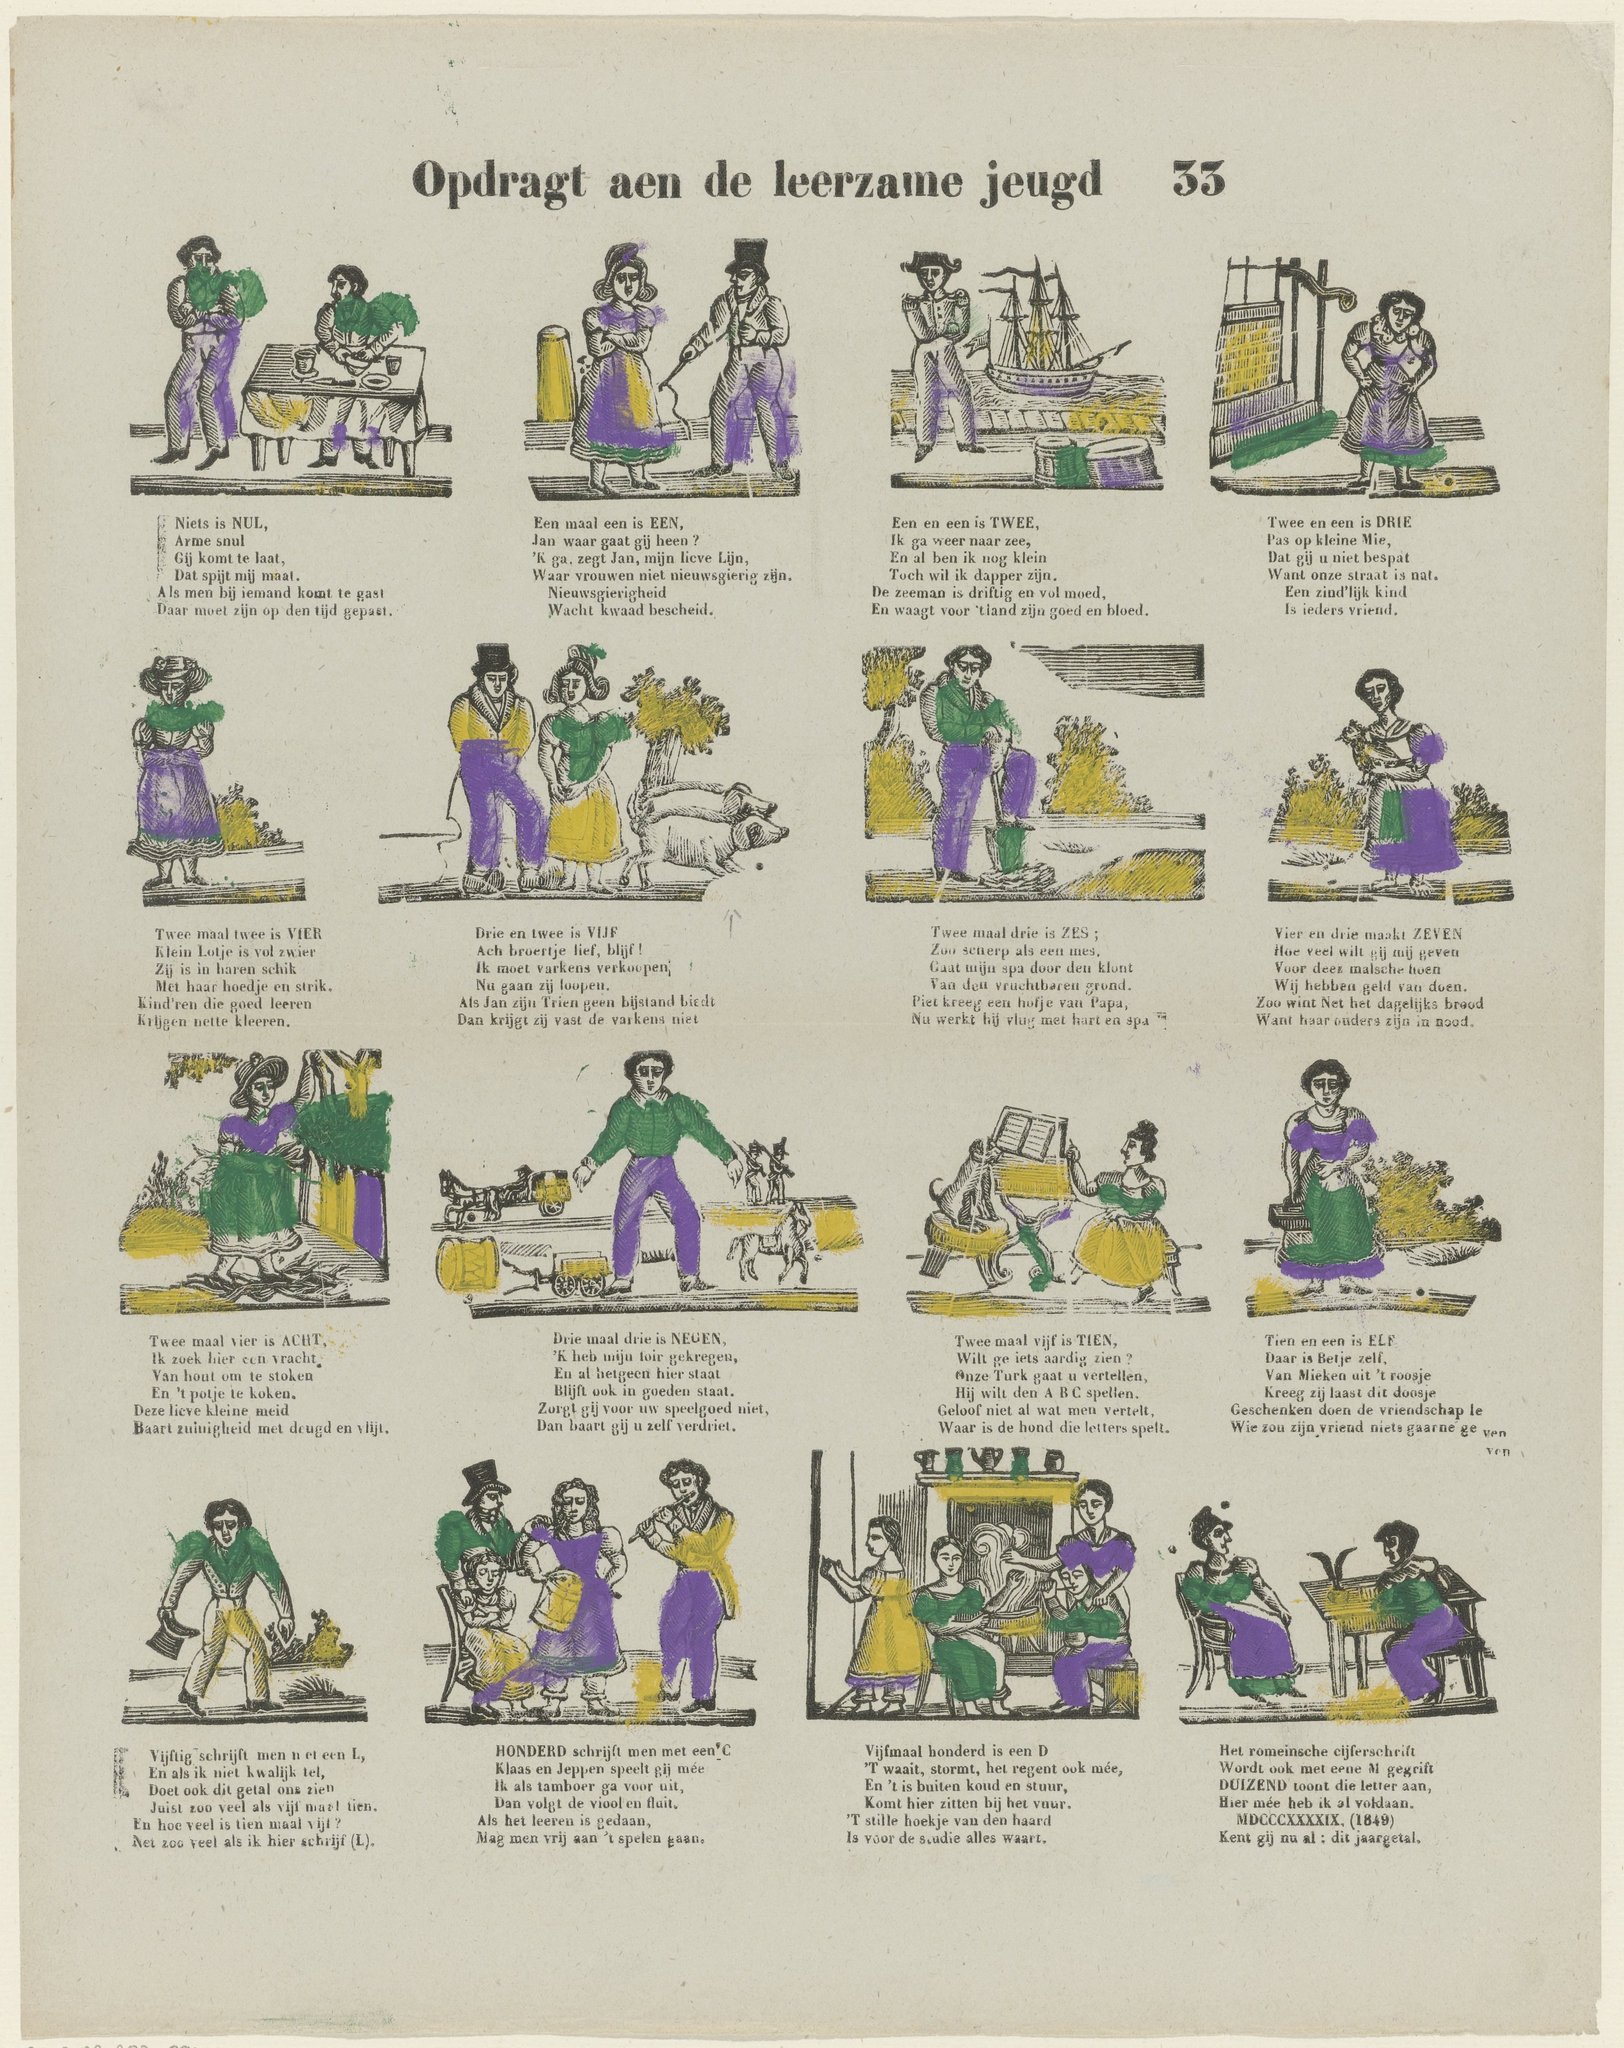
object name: popular print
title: Opdragt aen de leerzame jeugd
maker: Anonymous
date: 1856-1900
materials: paper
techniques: colour, letterpress printing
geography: turnhout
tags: characters (human types), counting, calculating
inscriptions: collector's mark: Lugt 2760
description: Blad met 16 voorstellingen van verschillende figuren. Onder elke afbeelding een versje met een rekensom. Genummerd rechtsboven: 33.